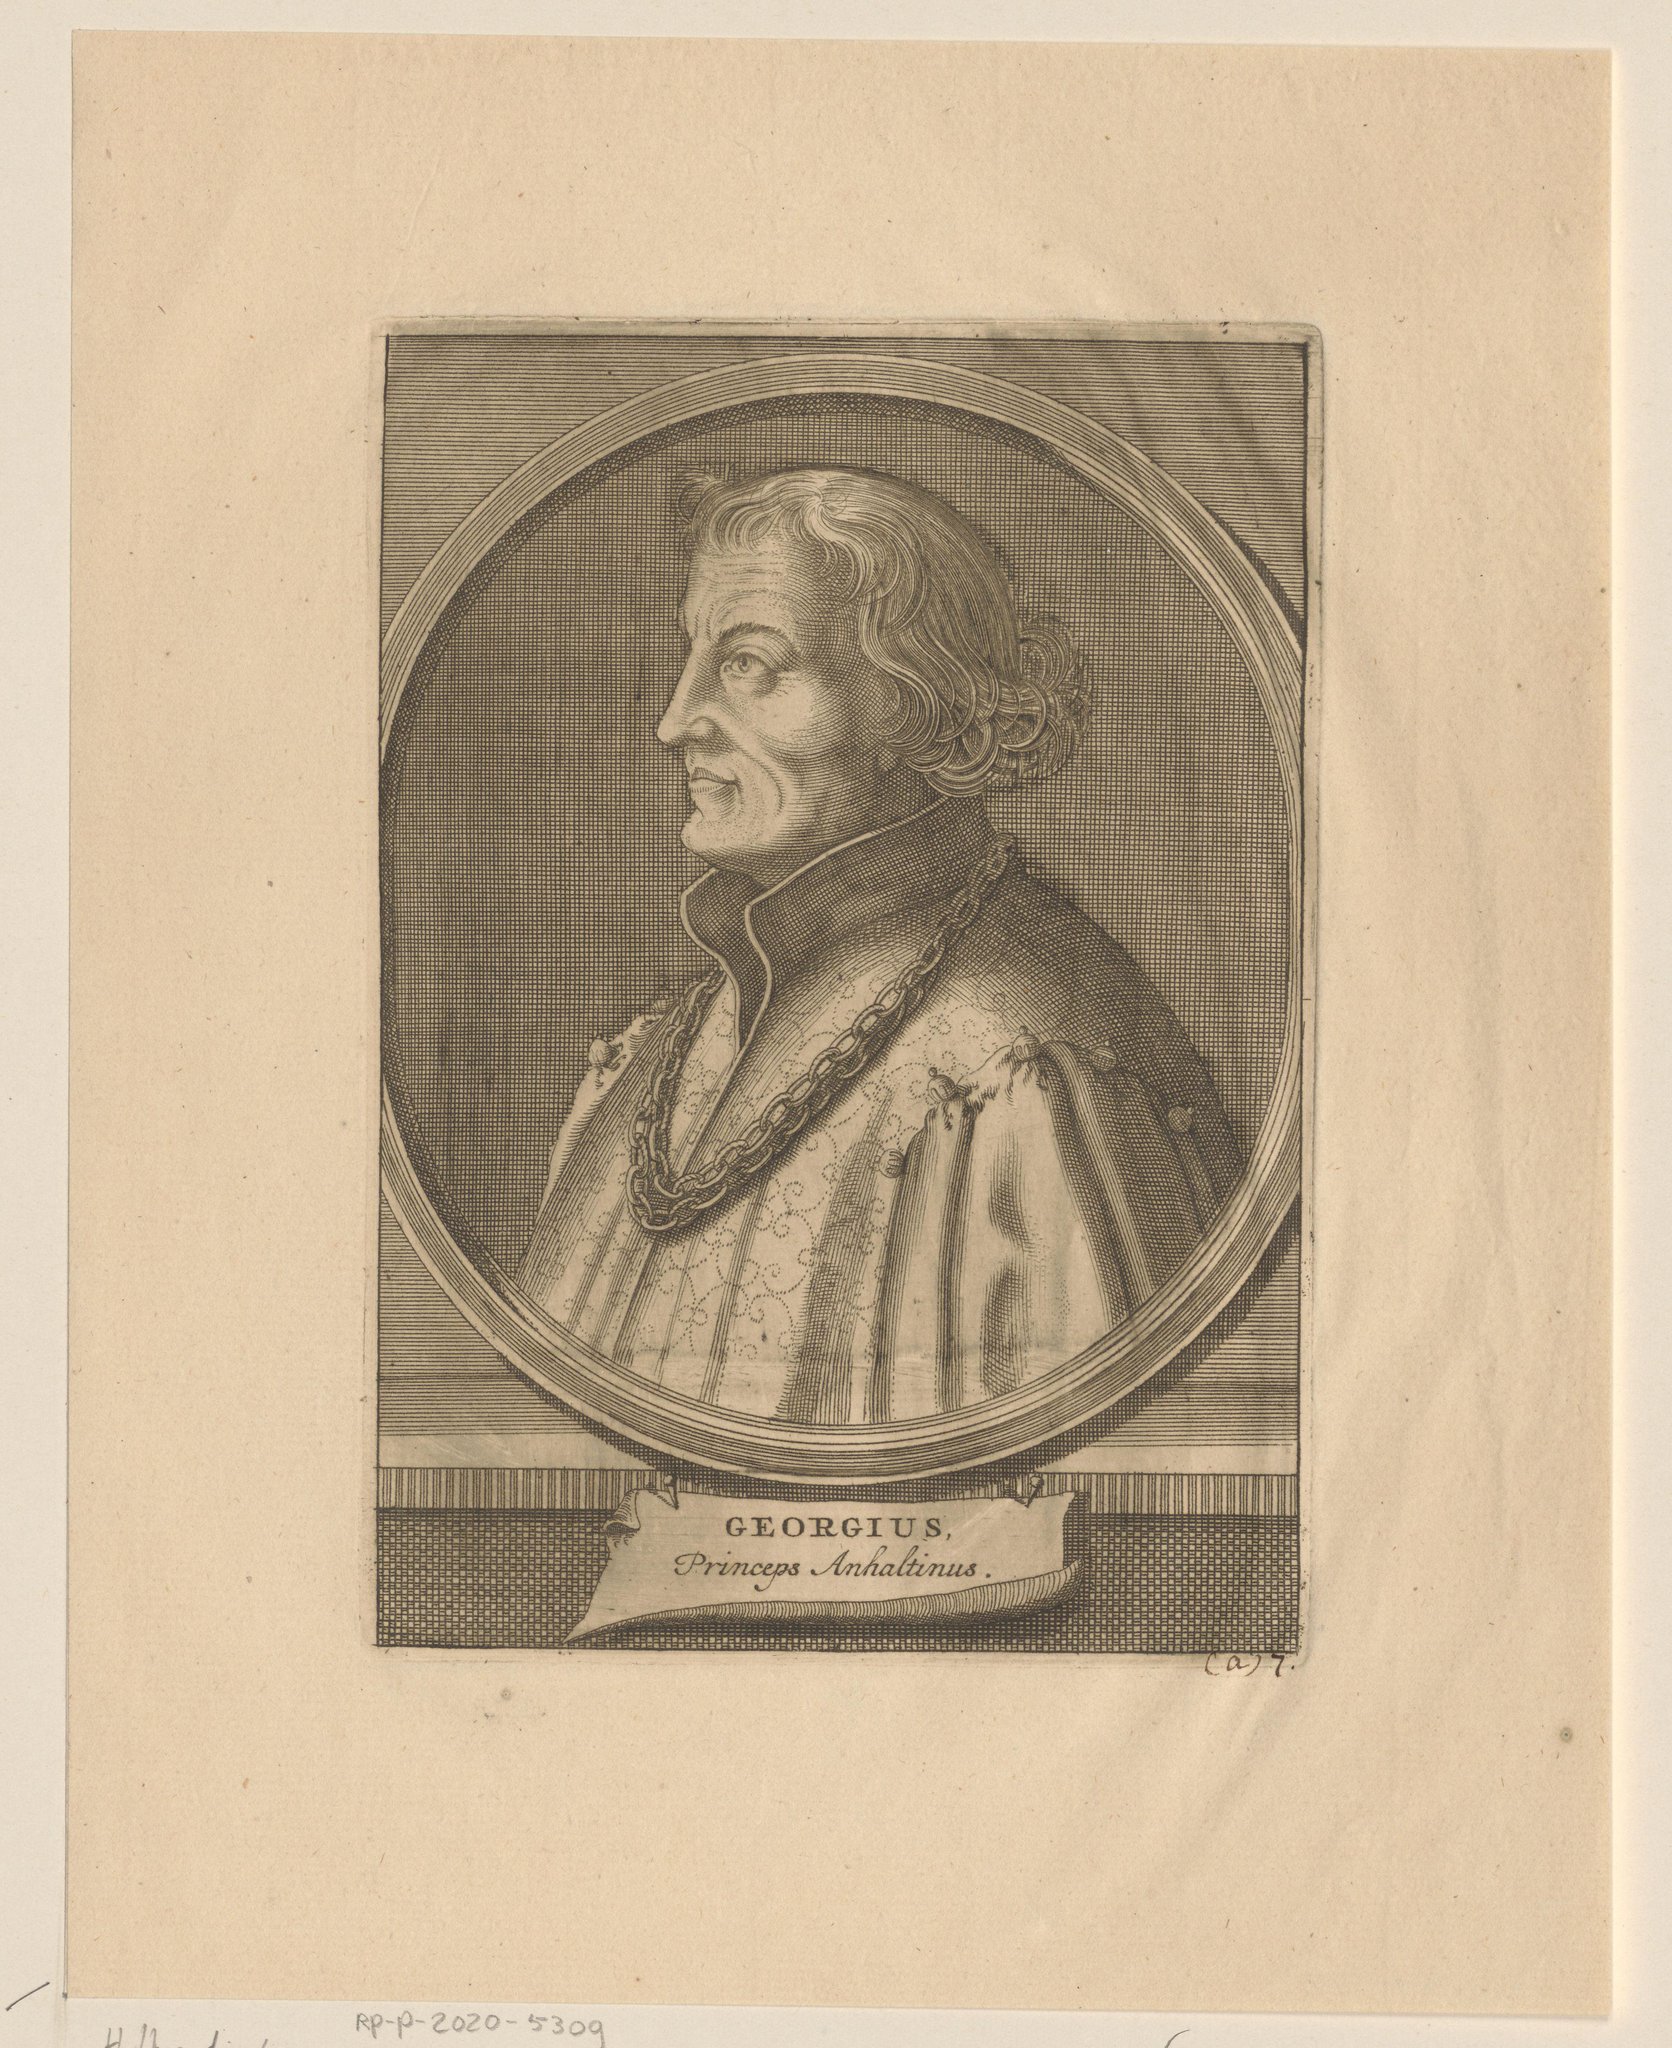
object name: print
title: Portret van Georg III von Anhalt-Plötzkau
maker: Anonymous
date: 1599-1699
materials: paper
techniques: engraving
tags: historical persons, politician, e.g. party leader